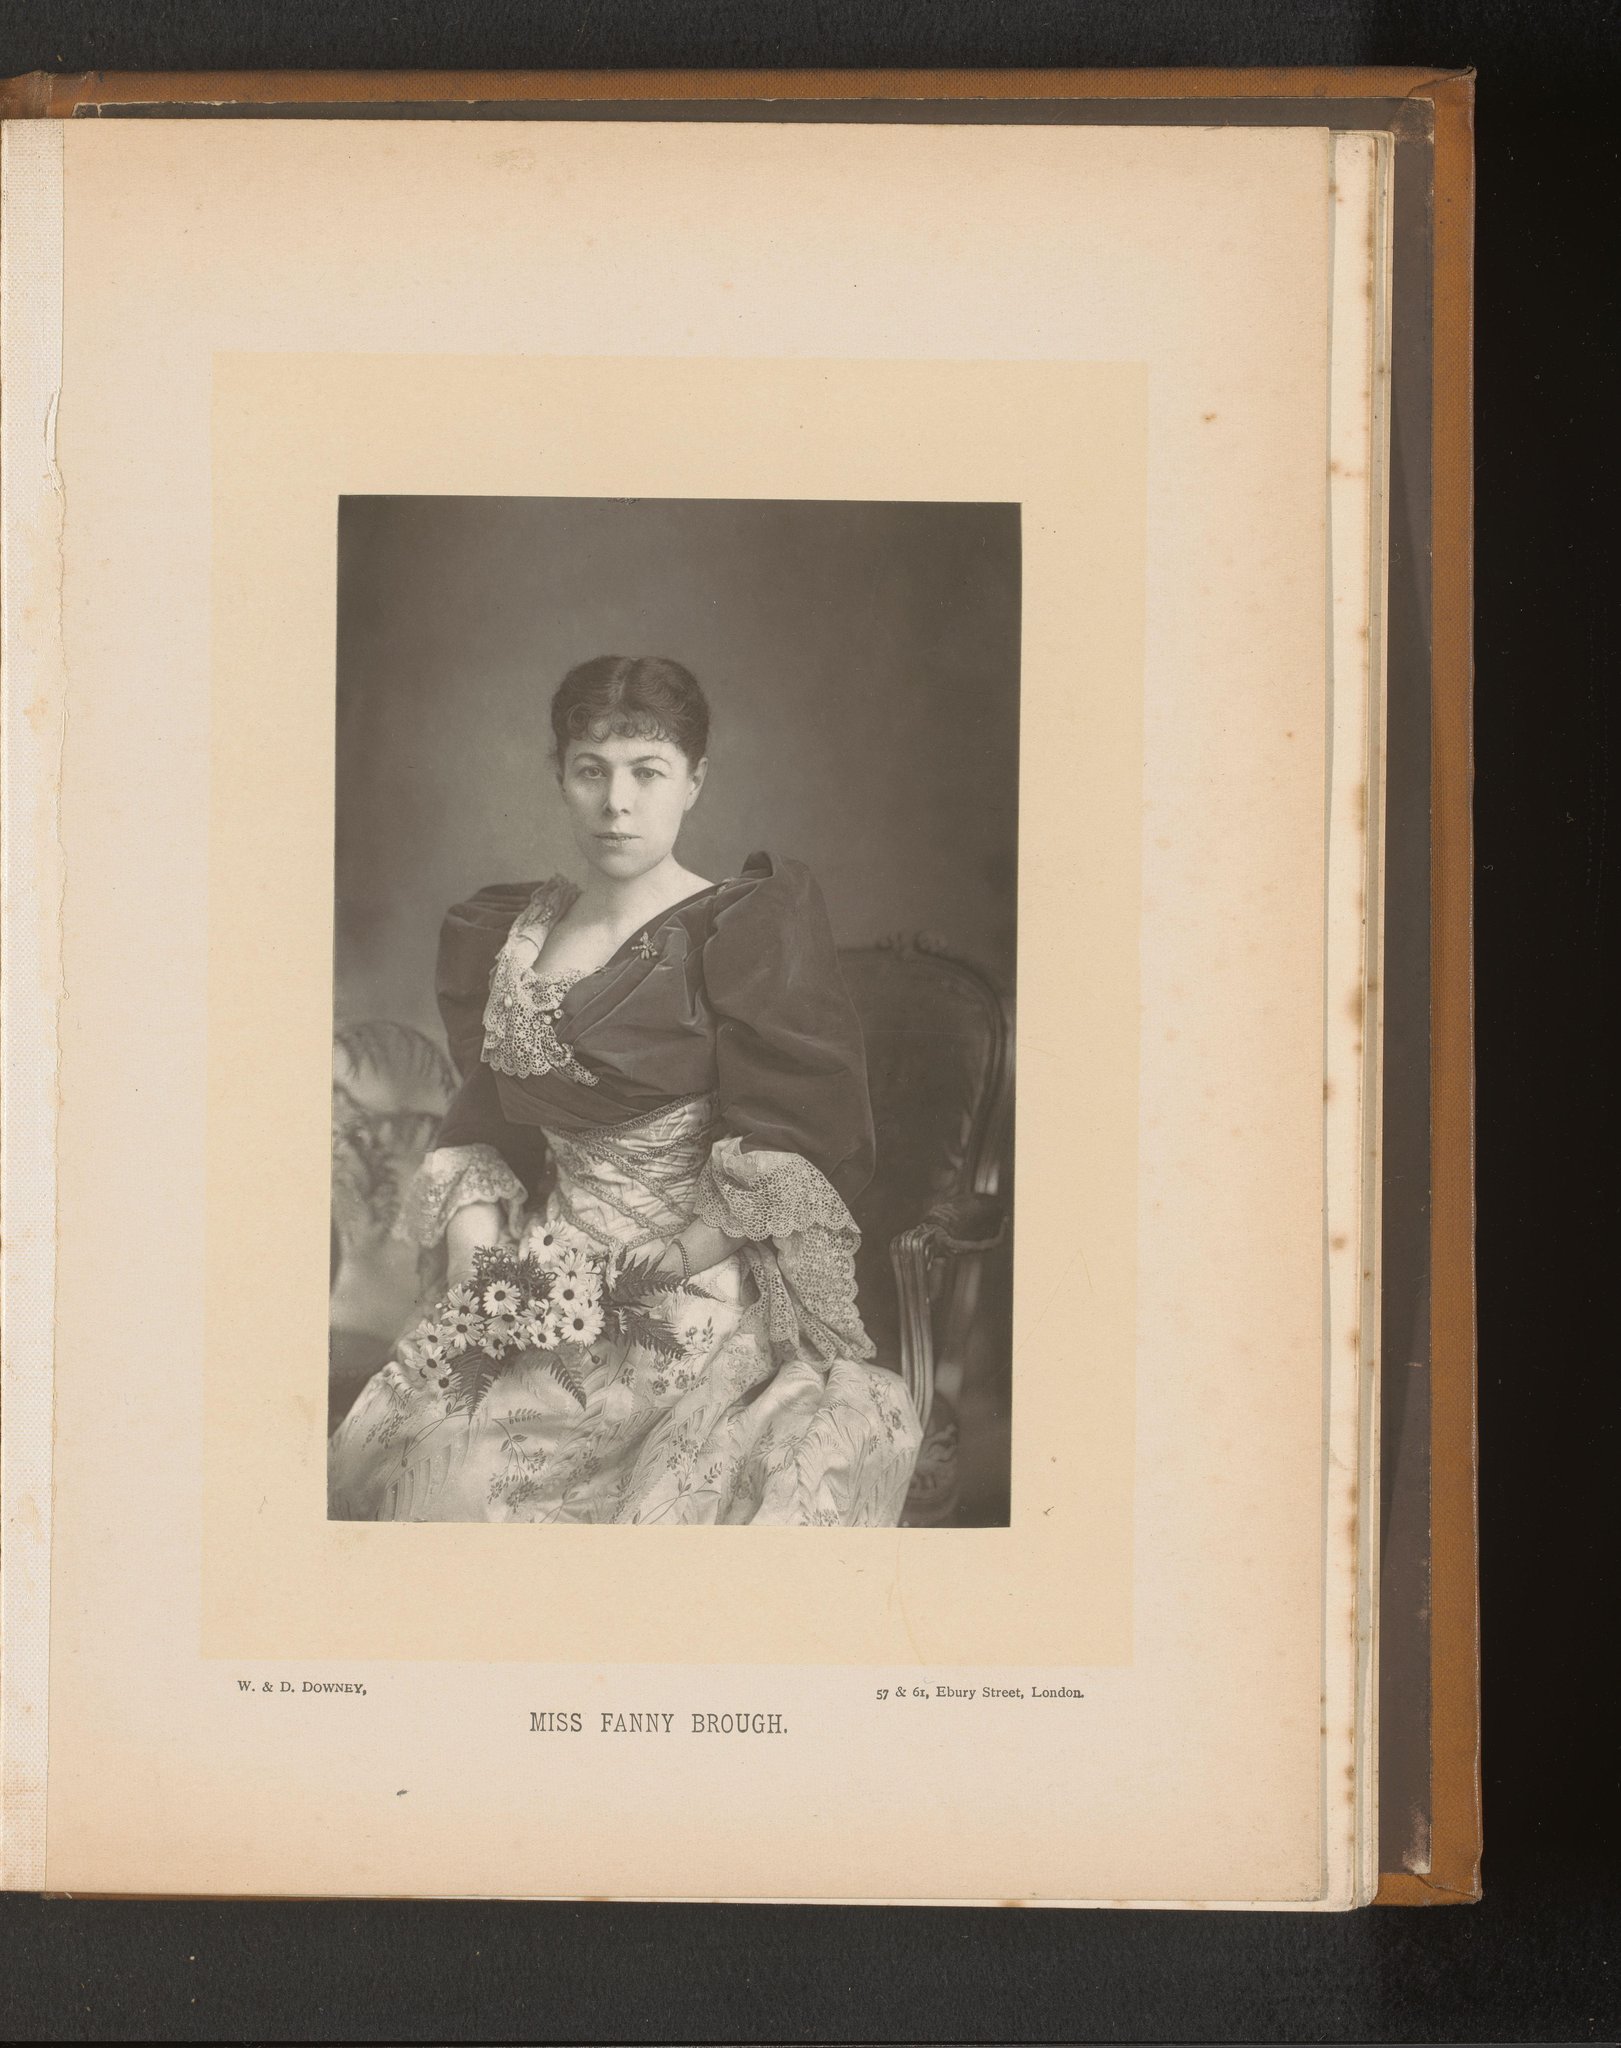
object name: page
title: Portret van Fanny Brough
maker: Anonymous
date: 1884-1894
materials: paper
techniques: woodburytype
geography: london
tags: portrait of actor, actress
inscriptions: inscription: ‘57 & 61, Elbury Street, London.’